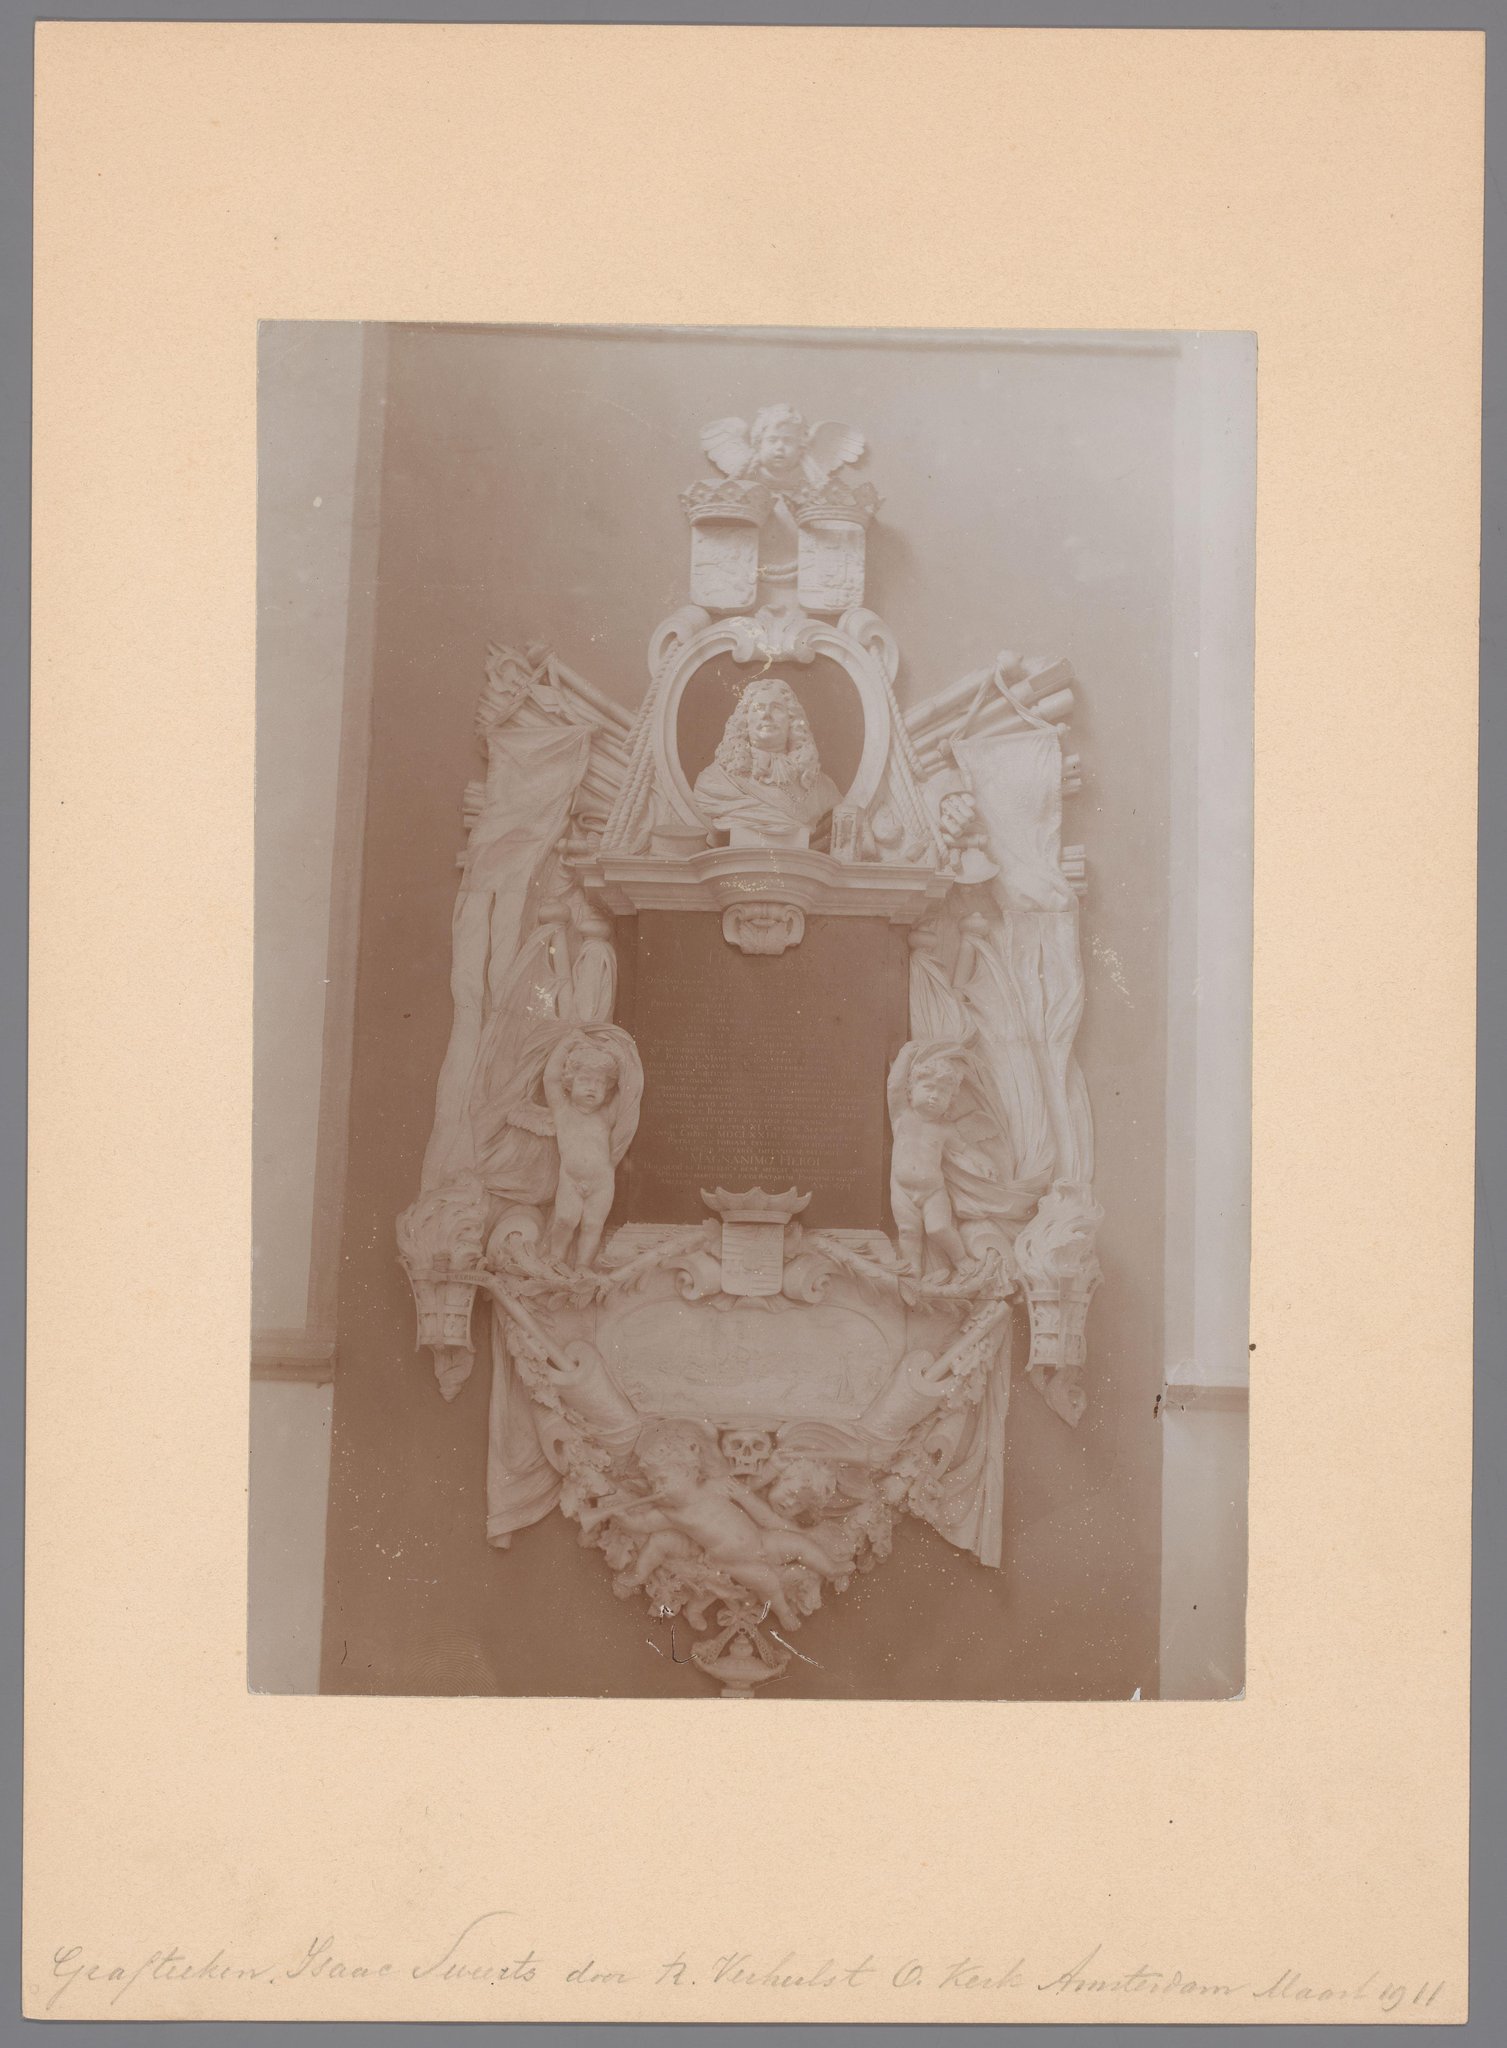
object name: photograph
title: Grafteken van Isaac Sweerts door Rombout Verhulst in de Oude Kerk te Amsterdam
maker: anoniem (monumentenzorg)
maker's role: fotograaf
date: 1911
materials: cardboard, photographic support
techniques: collodion silver print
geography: oude kerk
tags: grave, tomb, parts of church interior, piece of sculpture, reproduction of a piece of sculpture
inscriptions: annotation: ‘Grafteken, Isaac Sweerts door R. Verhulst O. Kerk Amsterdam Maart 1911’